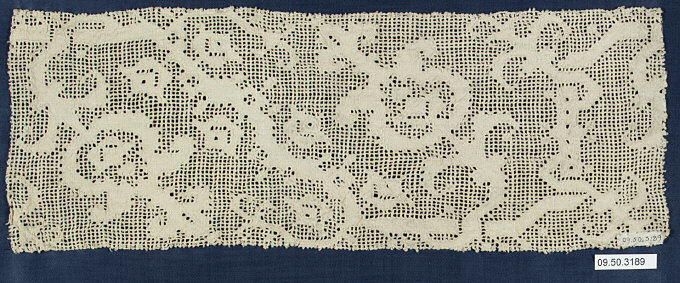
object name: band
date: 1501-1700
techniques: embroidery